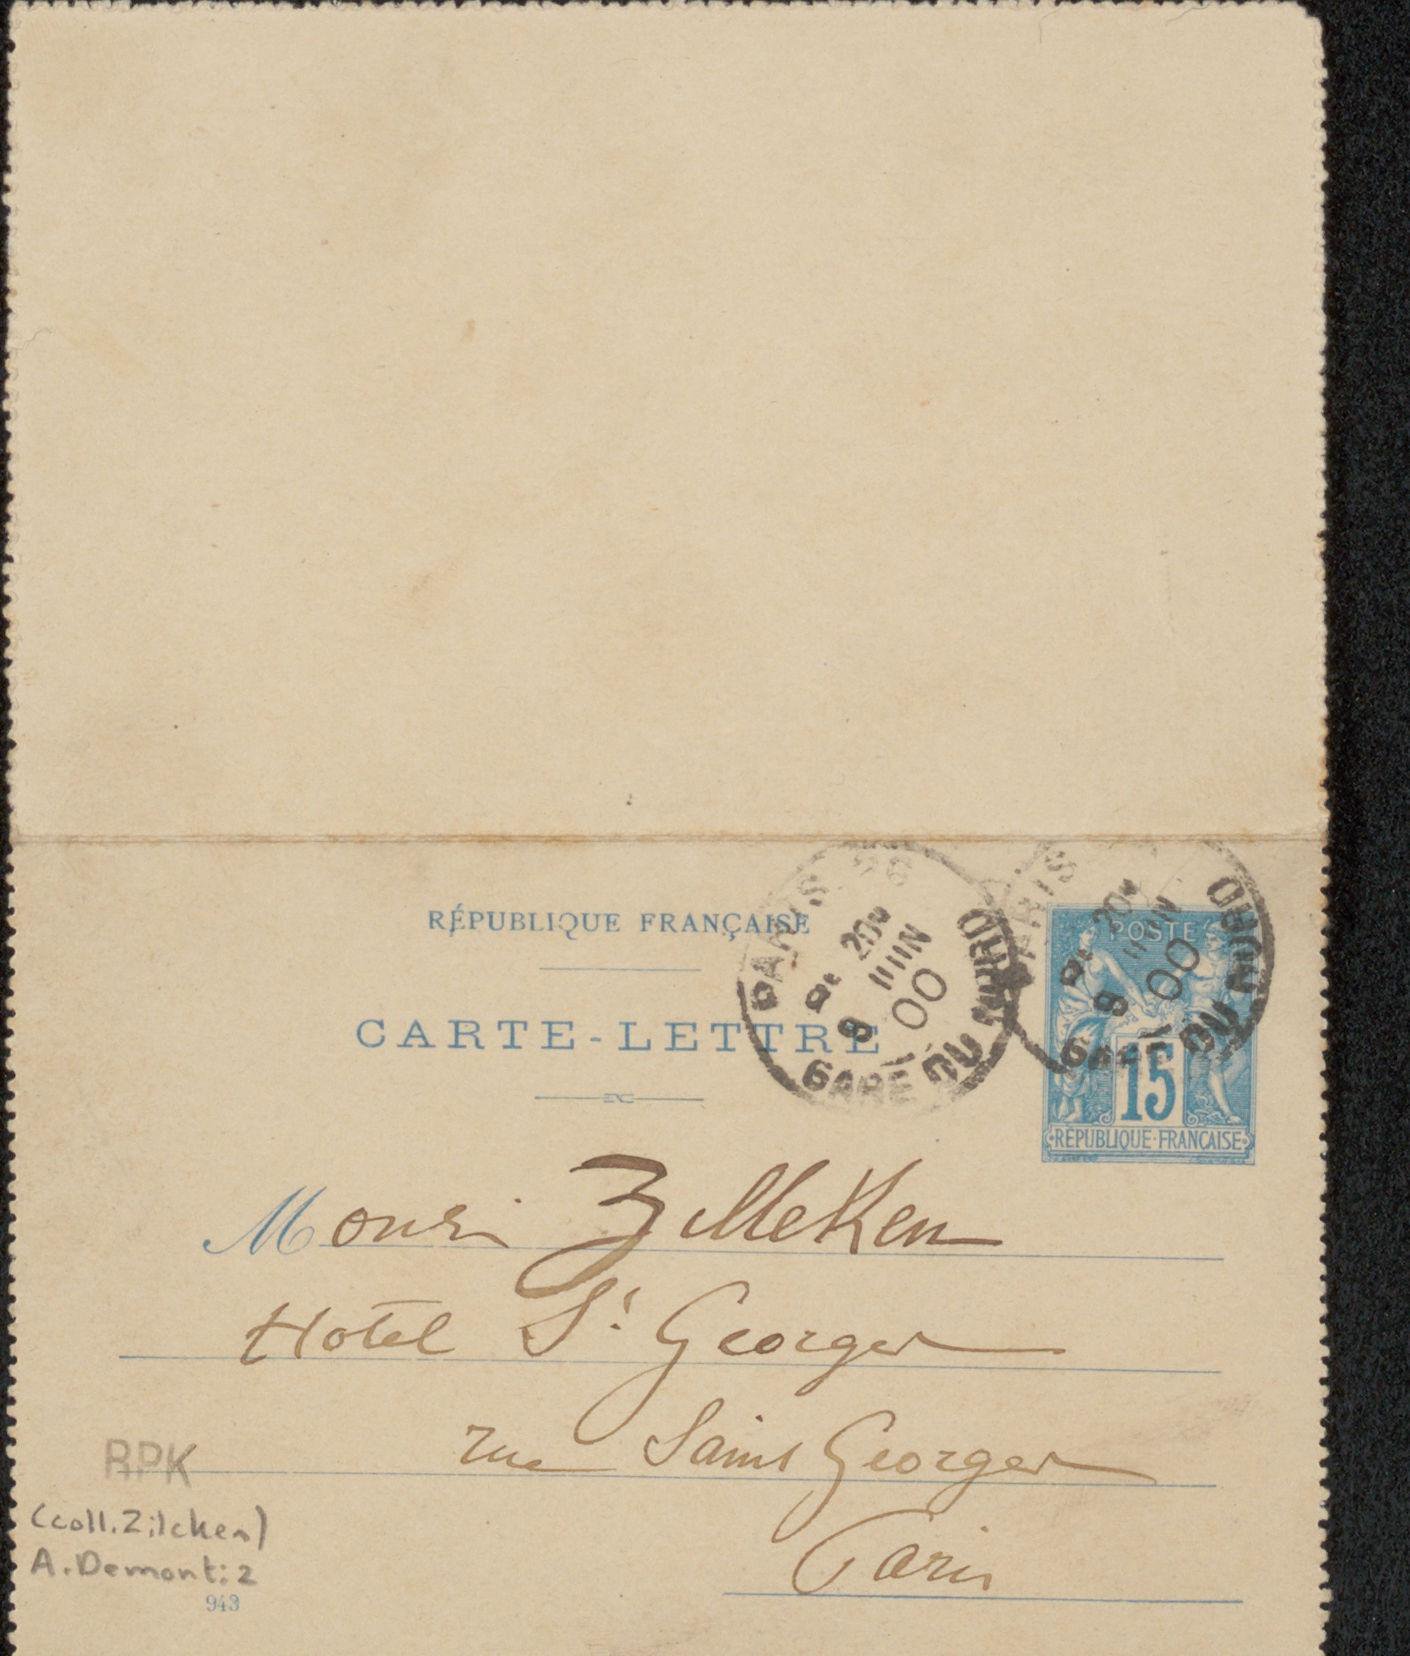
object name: postcard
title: Briefkaart aan Philip Zilcken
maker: adrien-louis demont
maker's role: painter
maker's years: 1851-1928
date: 1900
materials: cardboard, ink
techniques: pen, writing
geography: paris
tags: the hague, painter, philip zilcken, family life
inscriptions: collector's mark: ‘RPK’